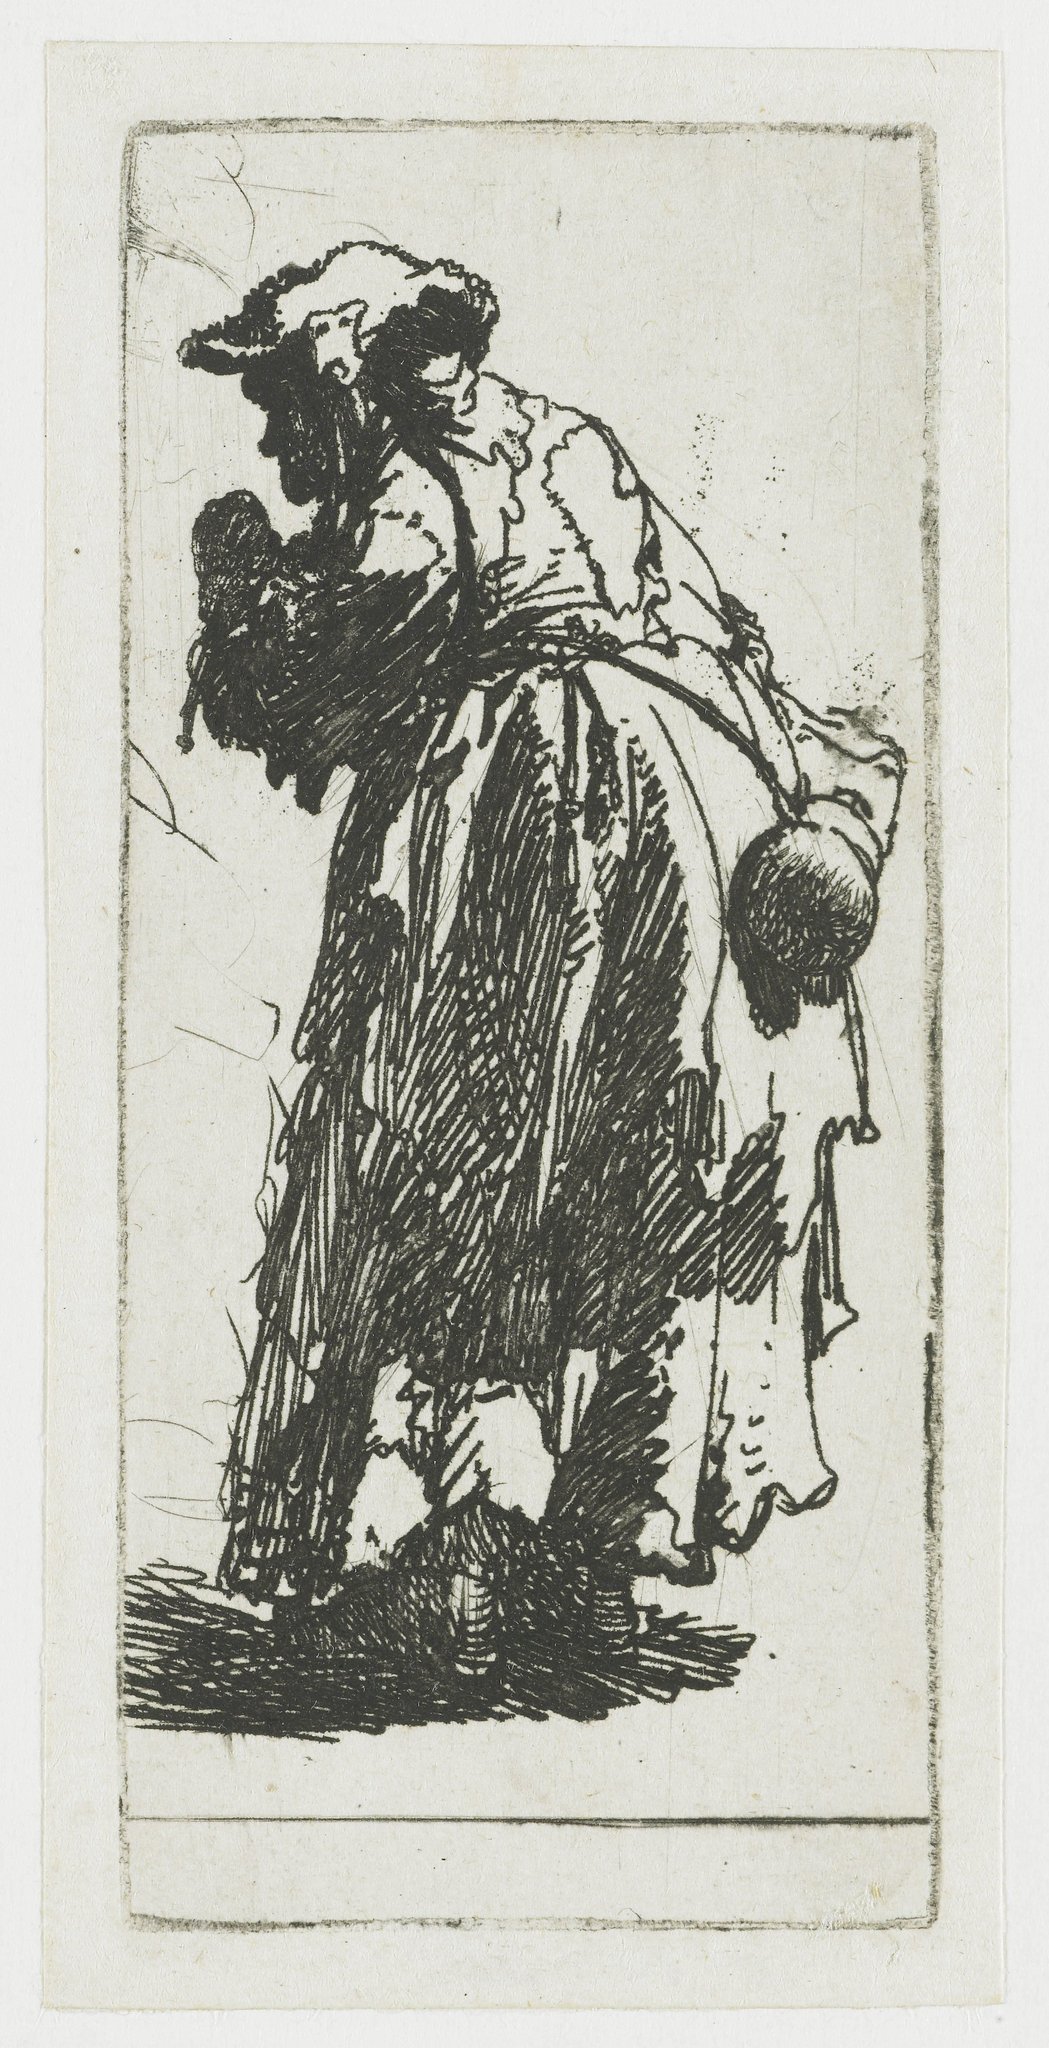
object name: print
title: Beggar Woman with a Gourd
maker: rembrandt van rijn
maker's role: draughtsman, painter, print maker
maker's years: 1606-1669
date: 1629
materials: paper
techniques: etching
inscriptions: collector's mark: Lugt 240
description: Rembrandt’s rapid progress as a printmaker is easy to see in this group of poor wretches. The seated woman is still somewhat crudely executed, but the beggar woman with a gourd and her male companion already testify to greater mastery of the technique. The little prints of a man and a woman are etched in the finer style that Rembrandt was to develop later.